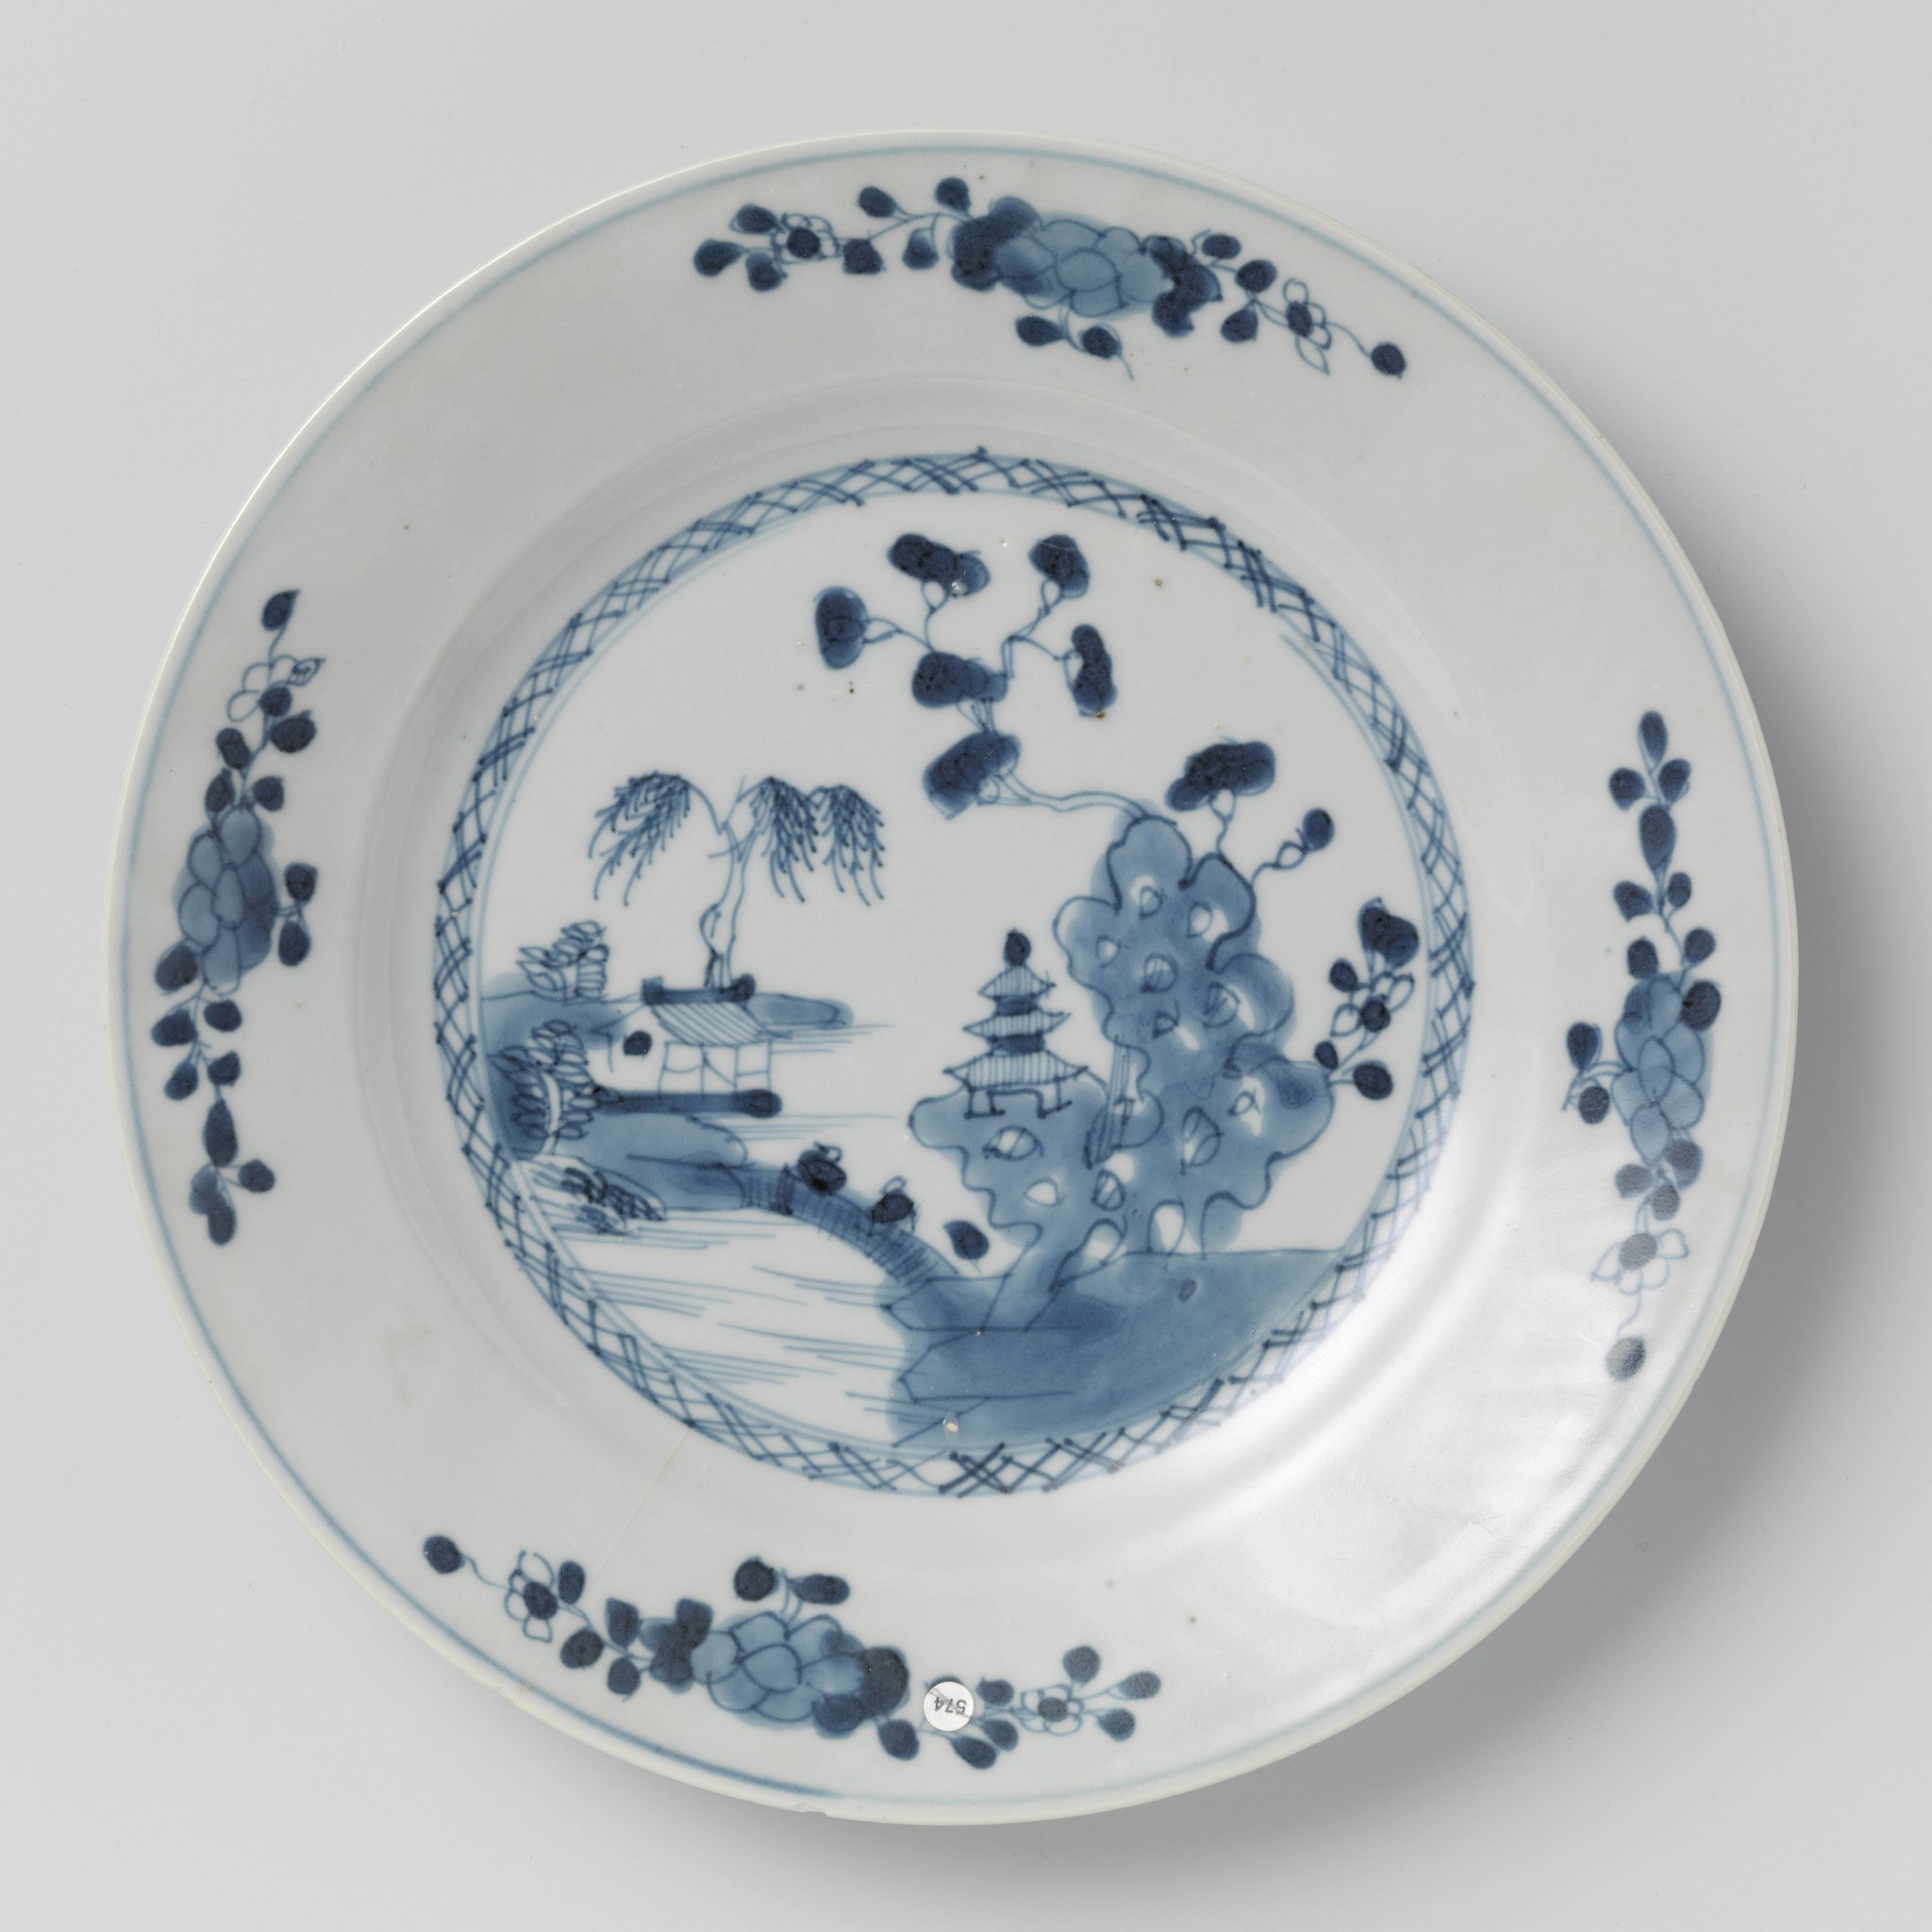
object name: plate dish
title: Plate with river landscape and flower sprays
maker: Anonymous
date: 1740-1760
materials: cobalt, glaze, paint, porcelain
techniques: firing, turning, vitrification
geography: china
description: Bord van porselein met ronde, korte wand en brede, schuine rand, beschilderd in onderglazuur blauw. Op het plat een rivierlandschap met twee personen op een brug, paviljoens, bomen en rotsen, hieromheen een band met geometrisch motief; op de rand vier keer een bloemtak. Een chip en een barst in de rand. Blauw-wit.